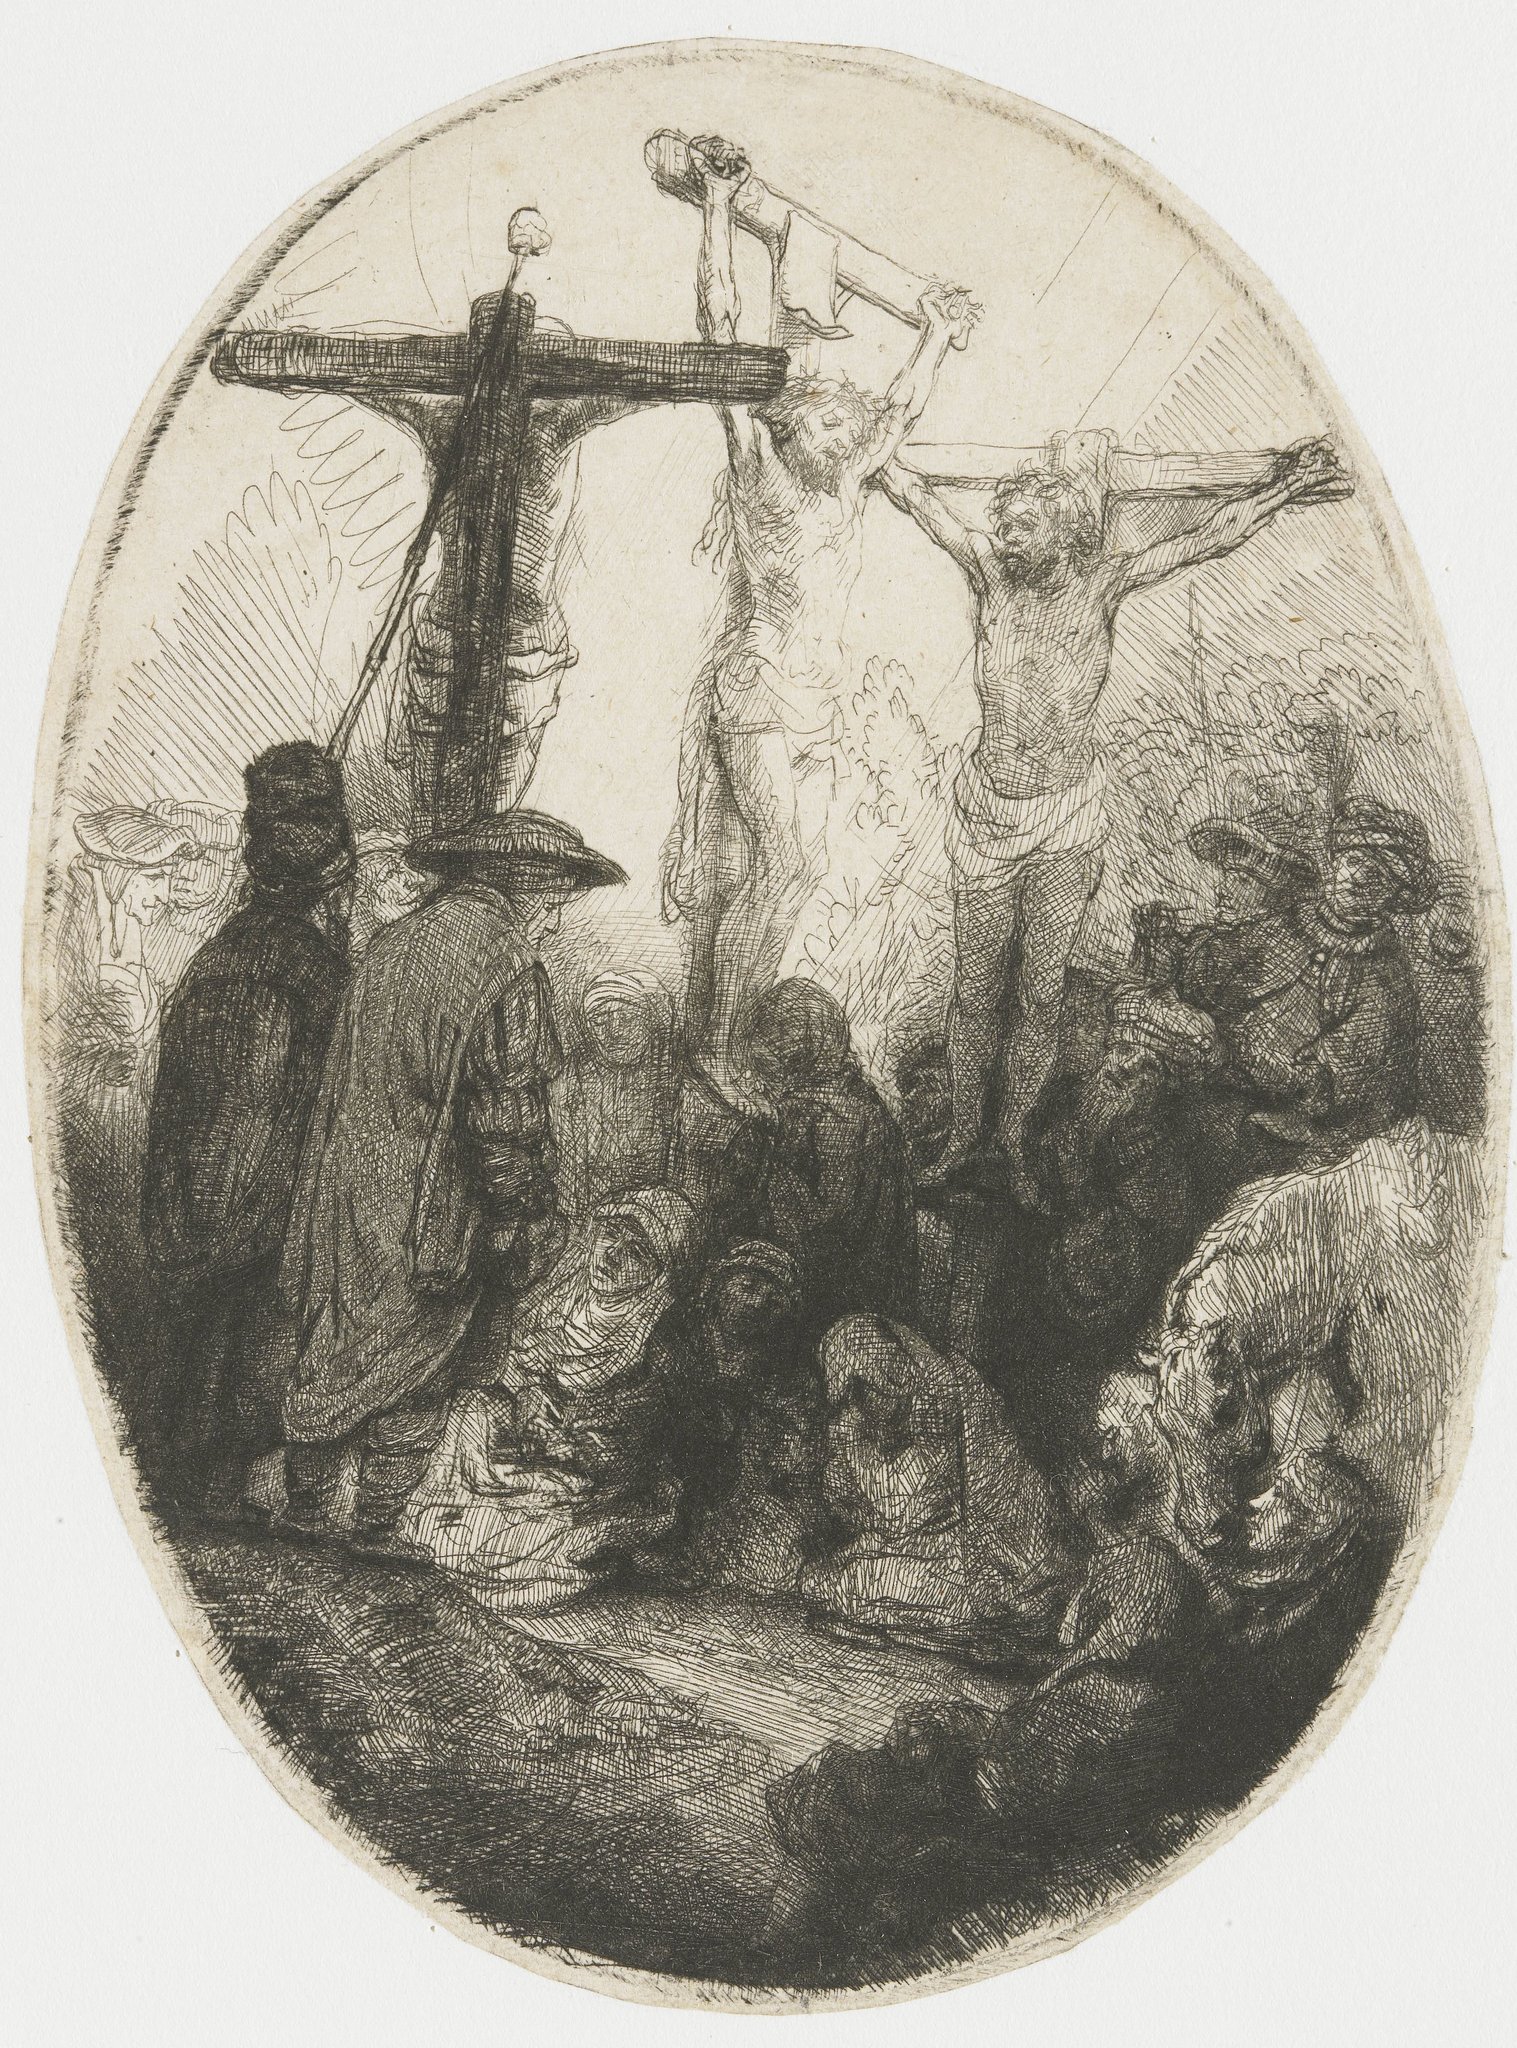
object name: print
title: Christ crucified between the two thieves: an oval plate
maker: rembrandt van rijn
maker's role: draughtsman, painter, print maker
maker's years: 1606-1669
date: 1641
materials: paper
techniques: drypoint, etching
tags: the crucifixion of christ: christ's death on the cross; golgotha (matthew 27:45-58; mark 15:33-45; luke 23:44-52; john 19:25-38)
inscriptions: collector's mark: ‘Remy 1745’ Lugt 2173, collector's mark: Lugt 2228, collector's mark: Lugt 439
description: Rembrandt depicted Christ on the Cross at different moments throughout his career. In the upper etching, the earliest of these two, he omitted the thieves who were crucified along with Christ. The Saviour looks at his mother, who returns his gaze and collapses. In the later print, Rembrandt did include the thieves, one of whom turns his attention to Christ.